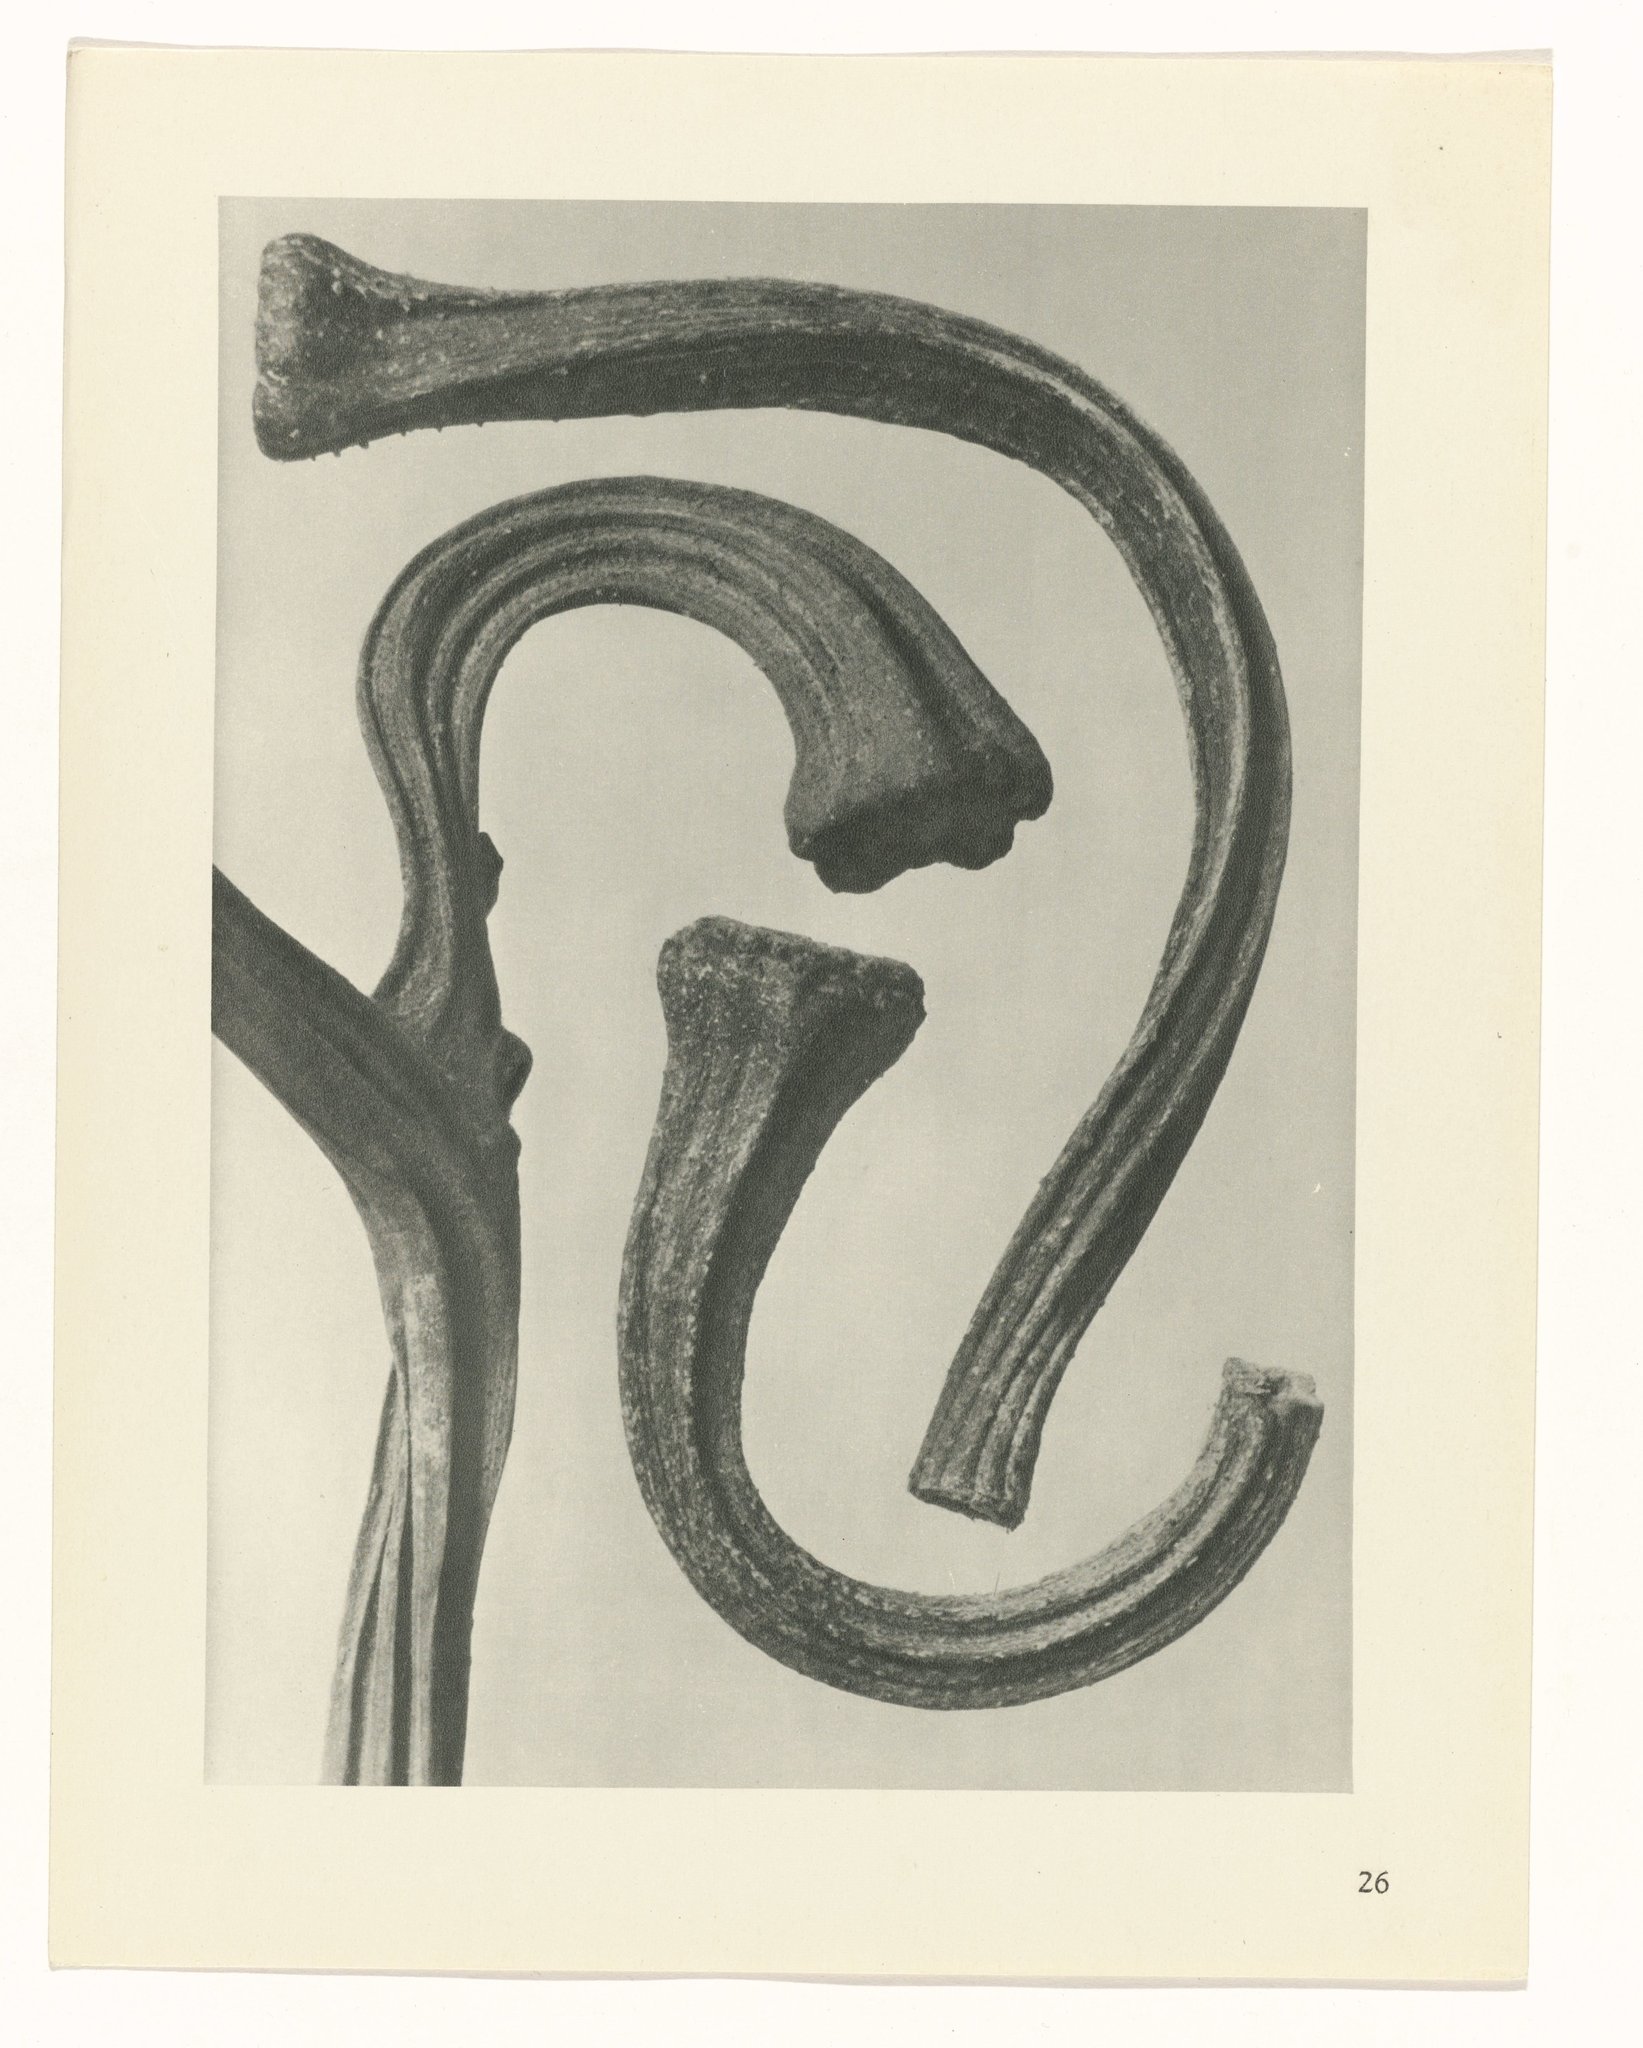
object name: photograph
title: Plantstudie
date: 1928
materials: ink, paper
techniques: rotogravure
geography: berlin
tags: plants (in general)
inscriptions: number: ‘26’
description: facher Vergrößerung. Afkomstig uit losbladige uitgave.